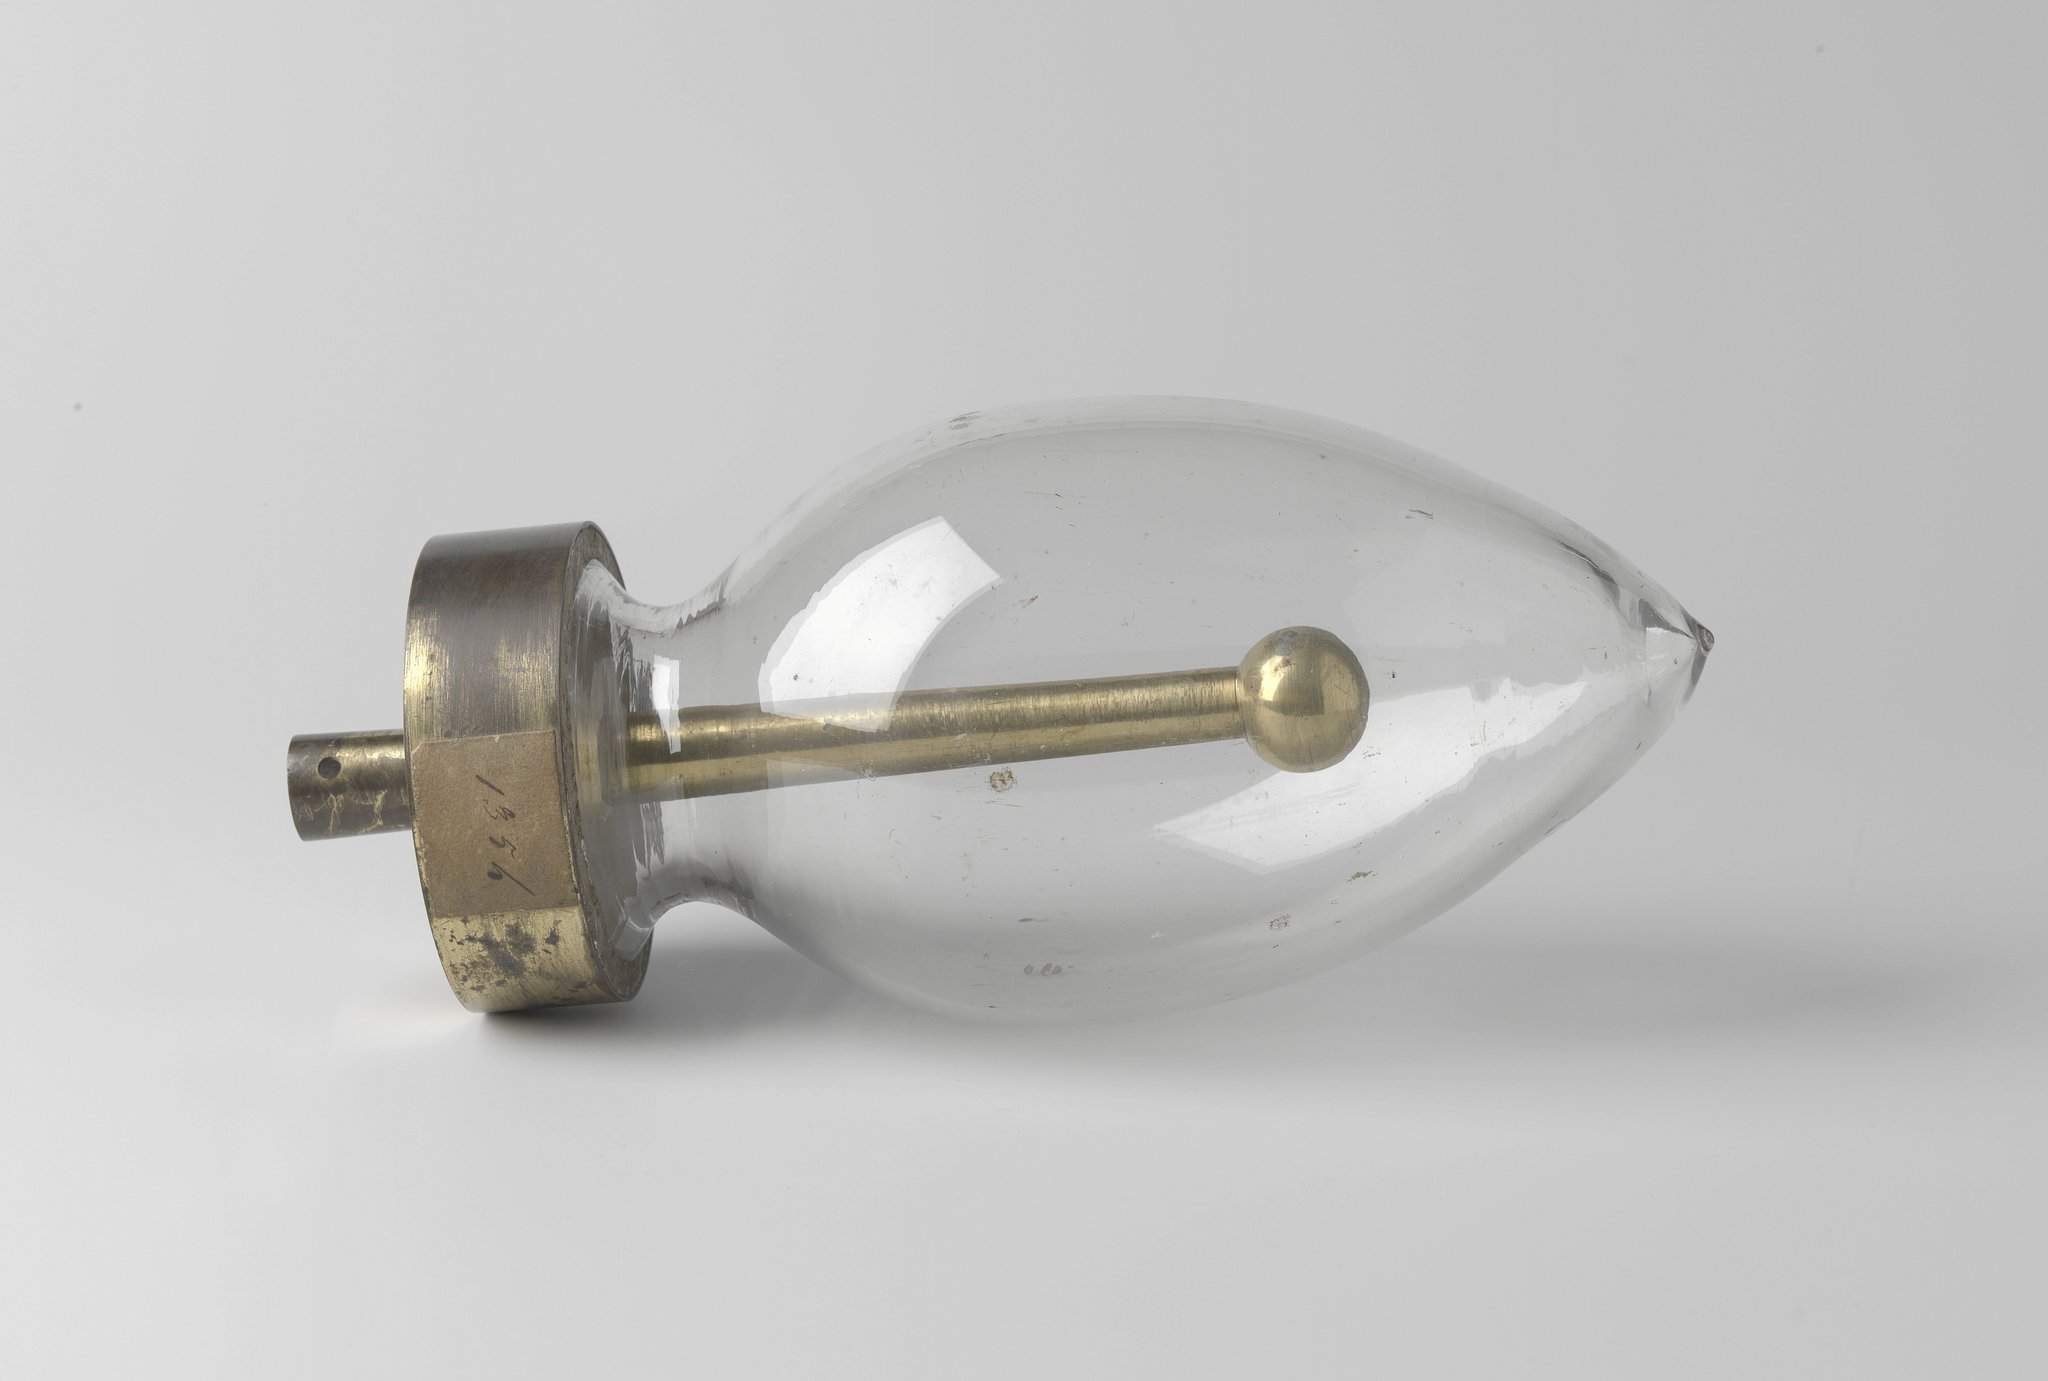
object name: lamp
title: Gas Lamp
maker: Anonymous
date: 1850-1900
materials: brass, glass